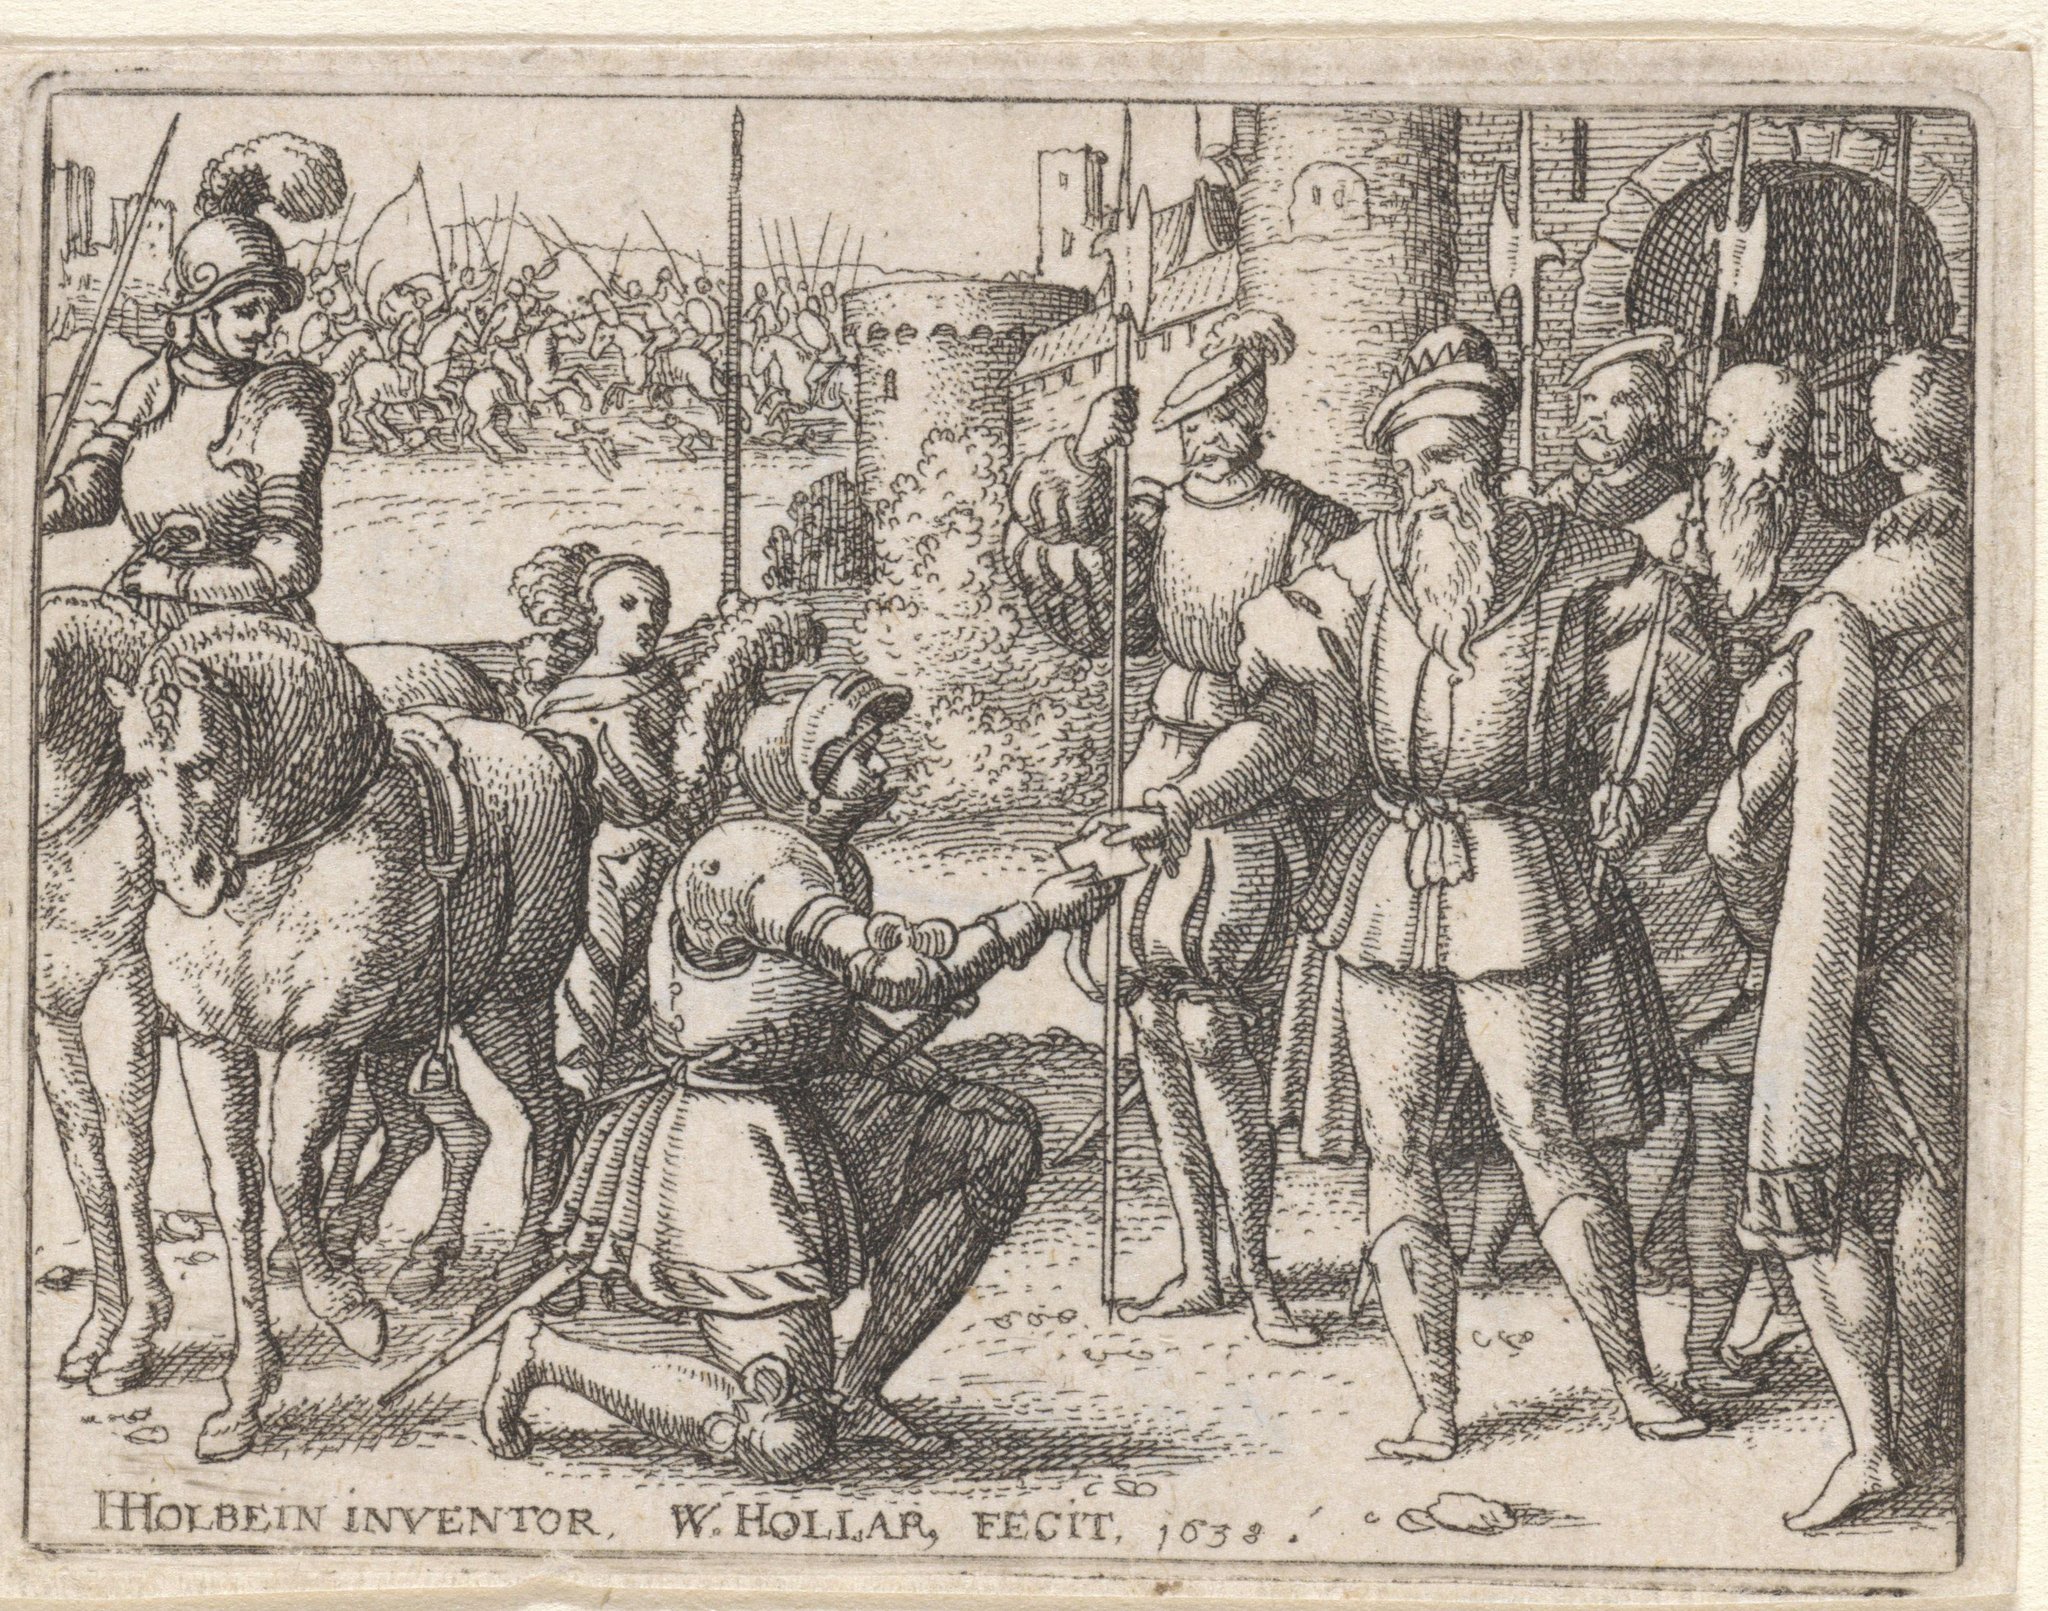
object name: print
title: David geeft Uria een brief voor Joab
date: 1638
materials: paper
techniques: etching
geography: london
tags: david gives uriah a letter for joab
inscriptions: collector's mark: Lugt 2228, collector's mark: Lugt 2227